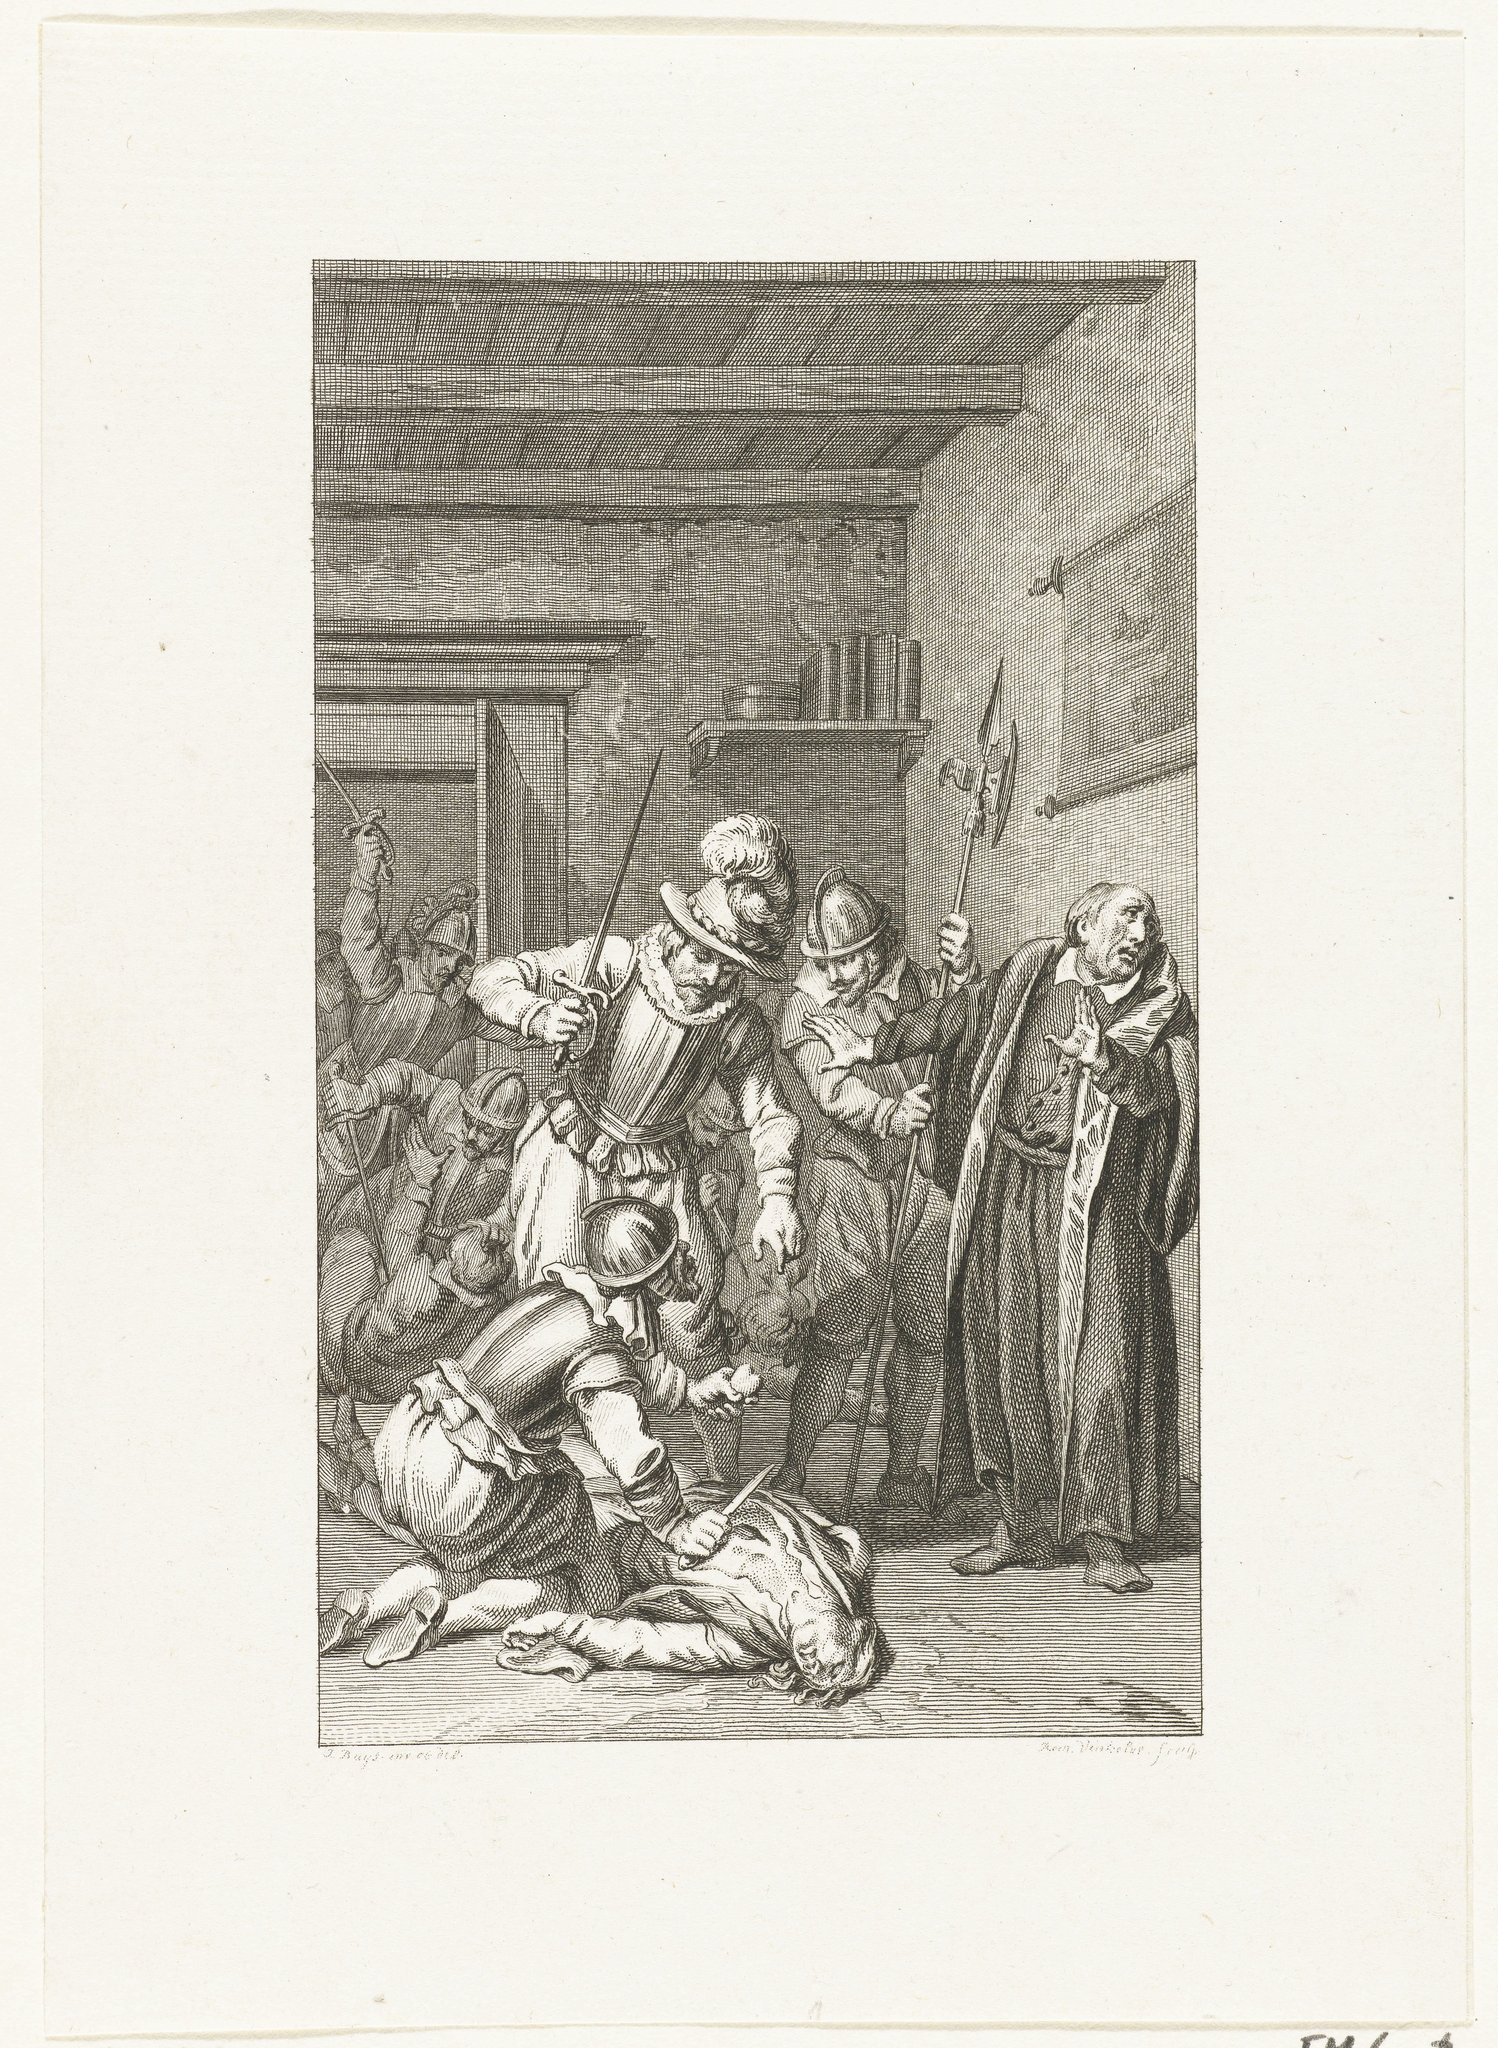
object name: print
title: De zoon van L. Hortensius gedood en verminkt door de Spanjaarden, 1572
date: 1790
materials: paper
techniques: etching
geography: netherlands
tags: priest, mutilation of the corpse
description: De Spanjaarden doden en snijden het hart uit het lichaam van Augustinus Hortensius, de zoon van Lambertus Hortensius, rector en geschiedschrijver te Naarden, 1 december 1572.